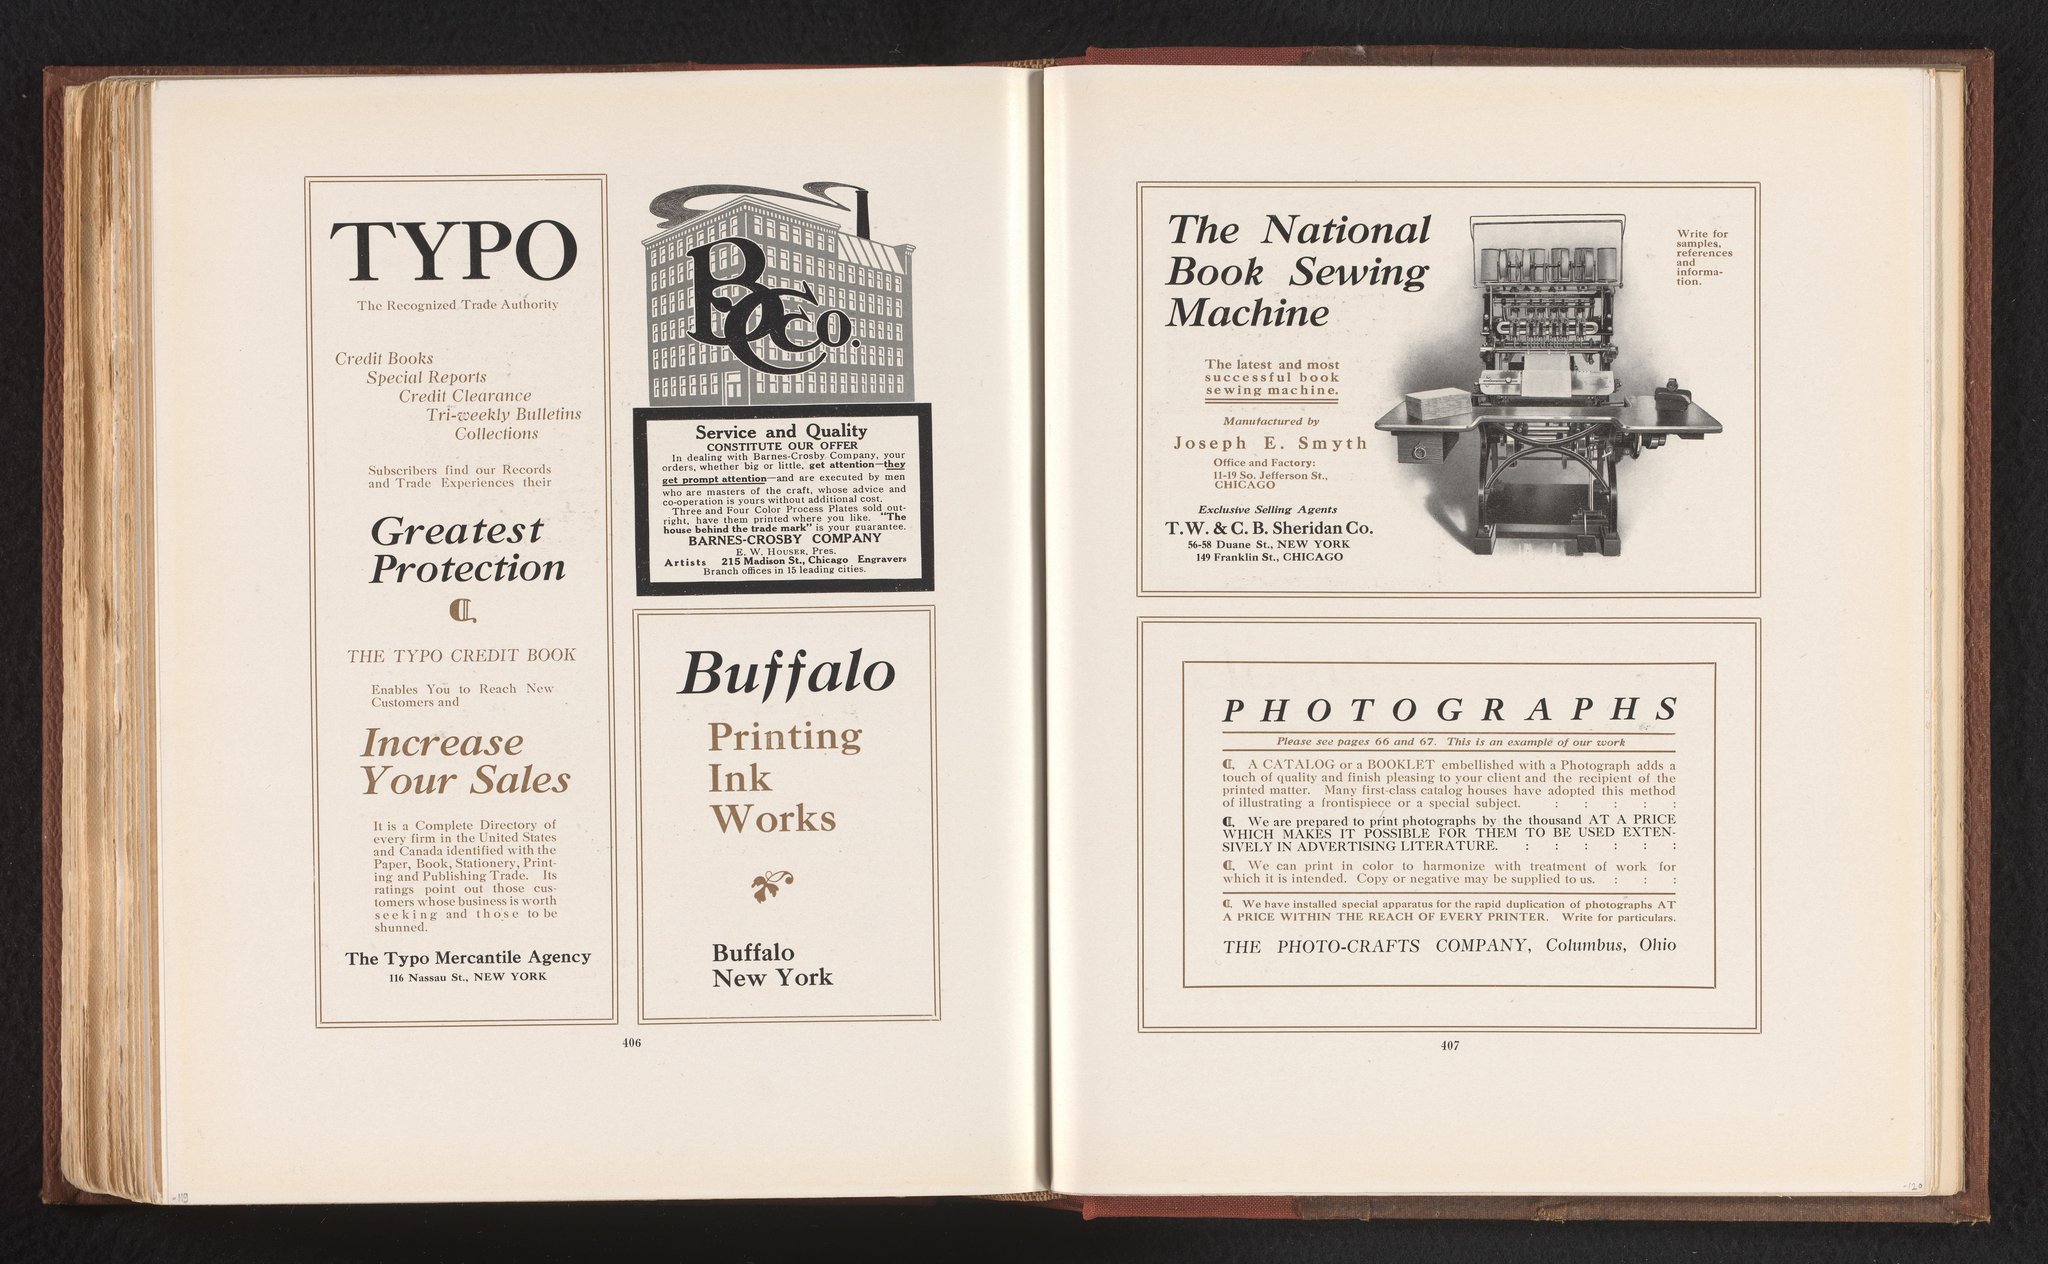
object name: advertisement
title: Reclames, waaronder voor de Barnes-Crosby Company, Chicago, geïllustreerd met een fabrieksgebouw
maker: Anonymous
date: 1904-1909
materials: paper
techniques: autotype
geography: chicago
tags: factory-building, advertising